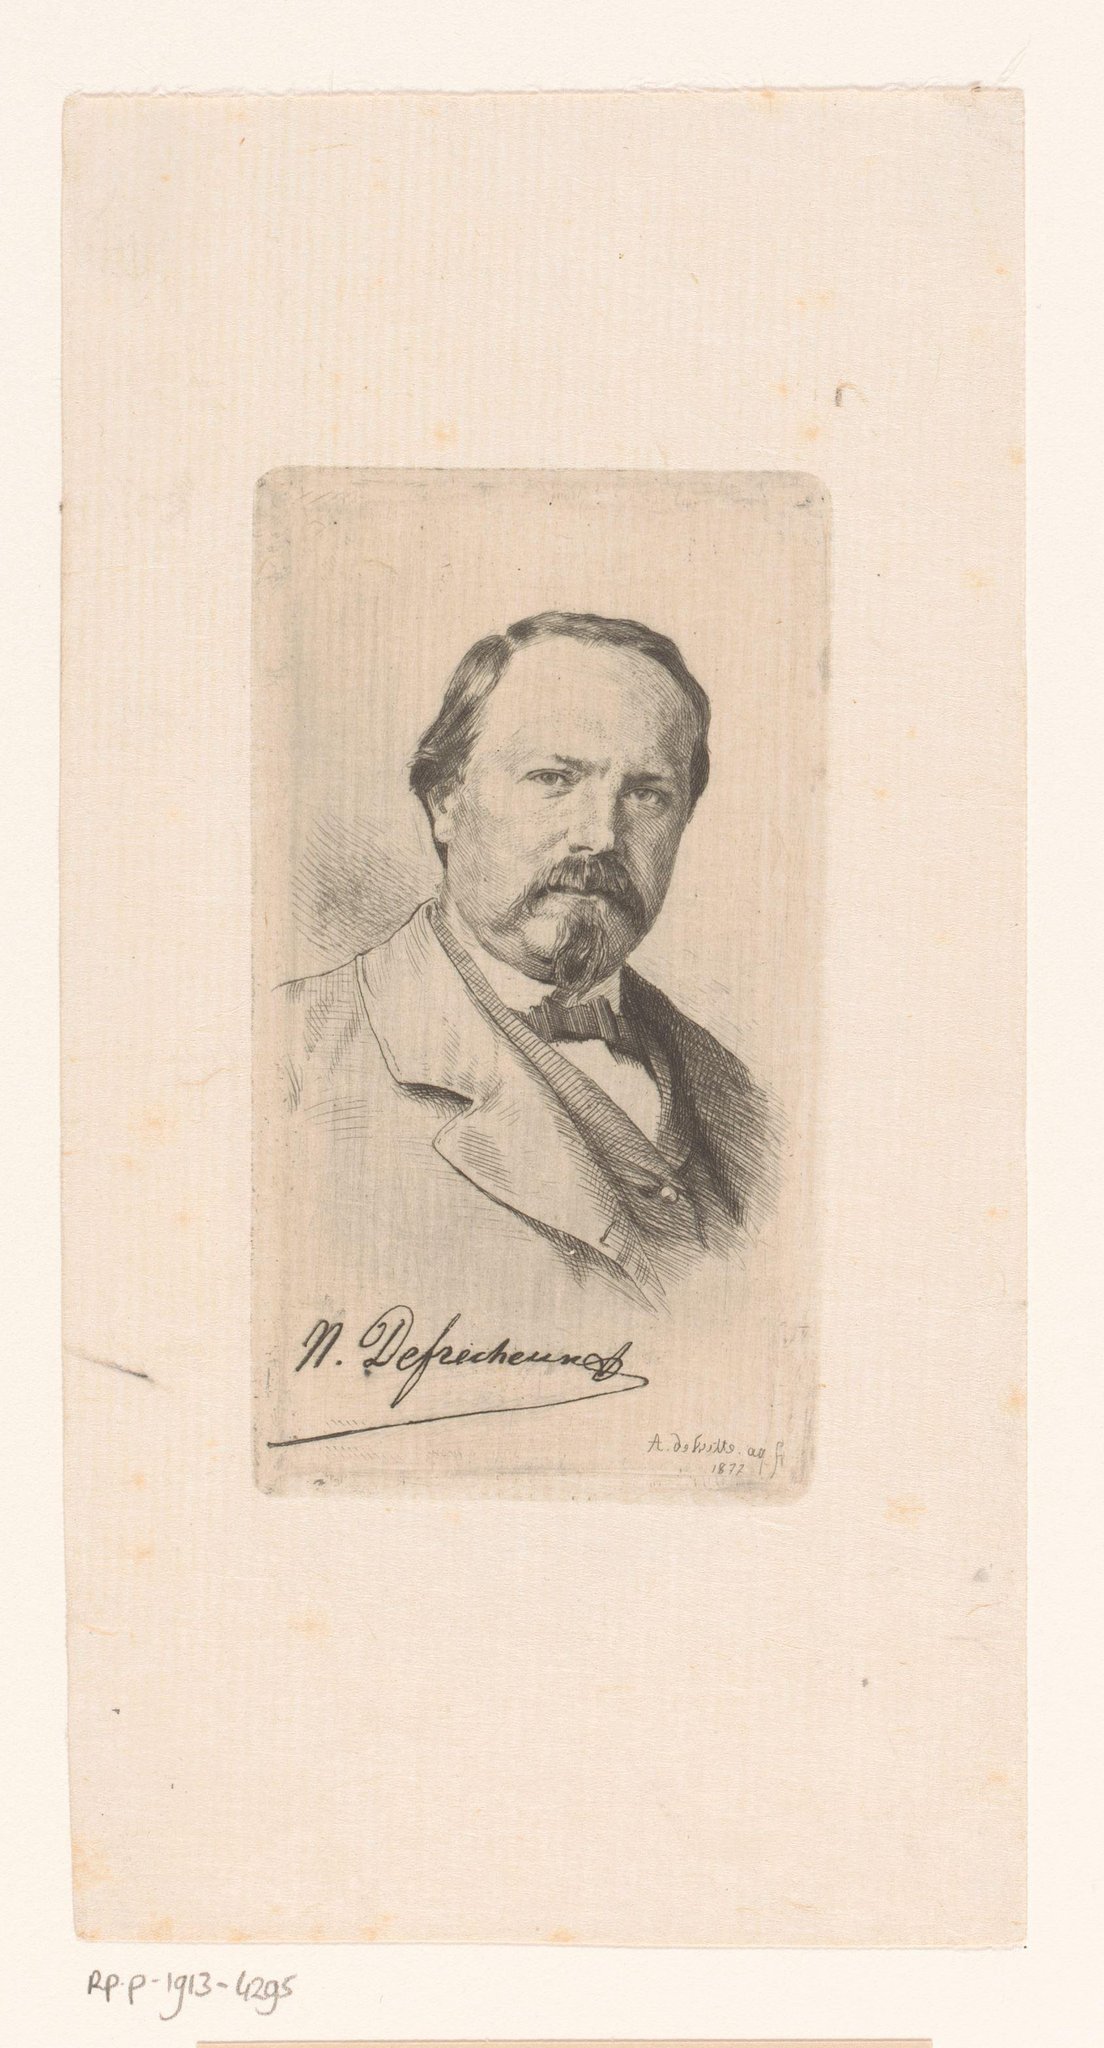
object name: print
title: Portret van Nicolas Defrêcheux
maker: adrien de witte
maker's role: print maker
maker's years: 1850-1935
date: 1877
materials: paper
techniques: etching, intaglio, retroussage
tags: moustache, adult man, historical persons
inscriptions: collector's mark: Lugt 2228